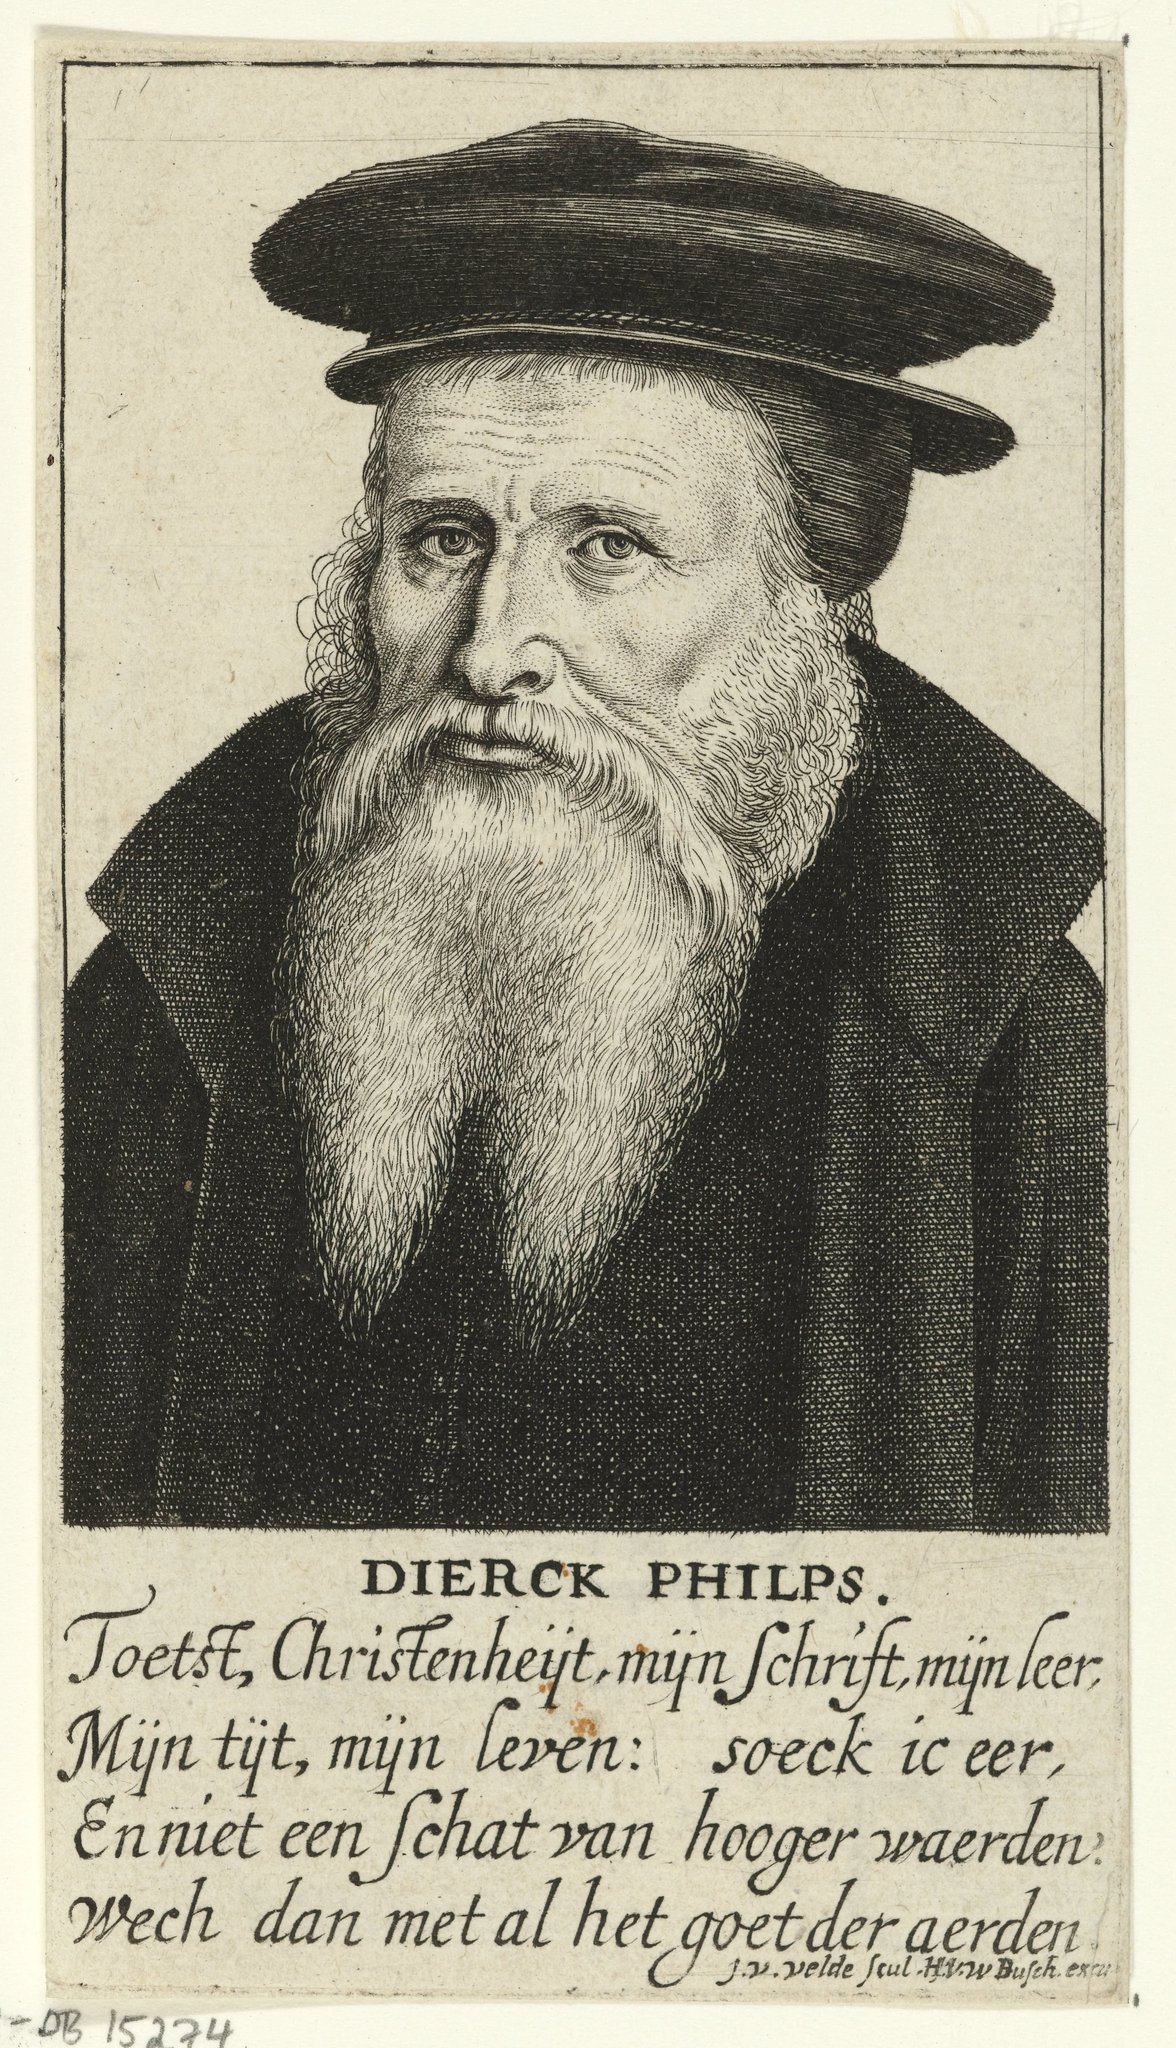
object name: print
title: Portret van Dirk Philips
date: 1623-1641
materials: paper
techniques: engraving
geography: haarlem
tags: historical persons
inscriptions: collector's mark: Lugt 964, collector's mark: Lugt 963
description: Portret van de doopsgezinde Dirk Philips, met vierregelig gedicht in het Nederlands.